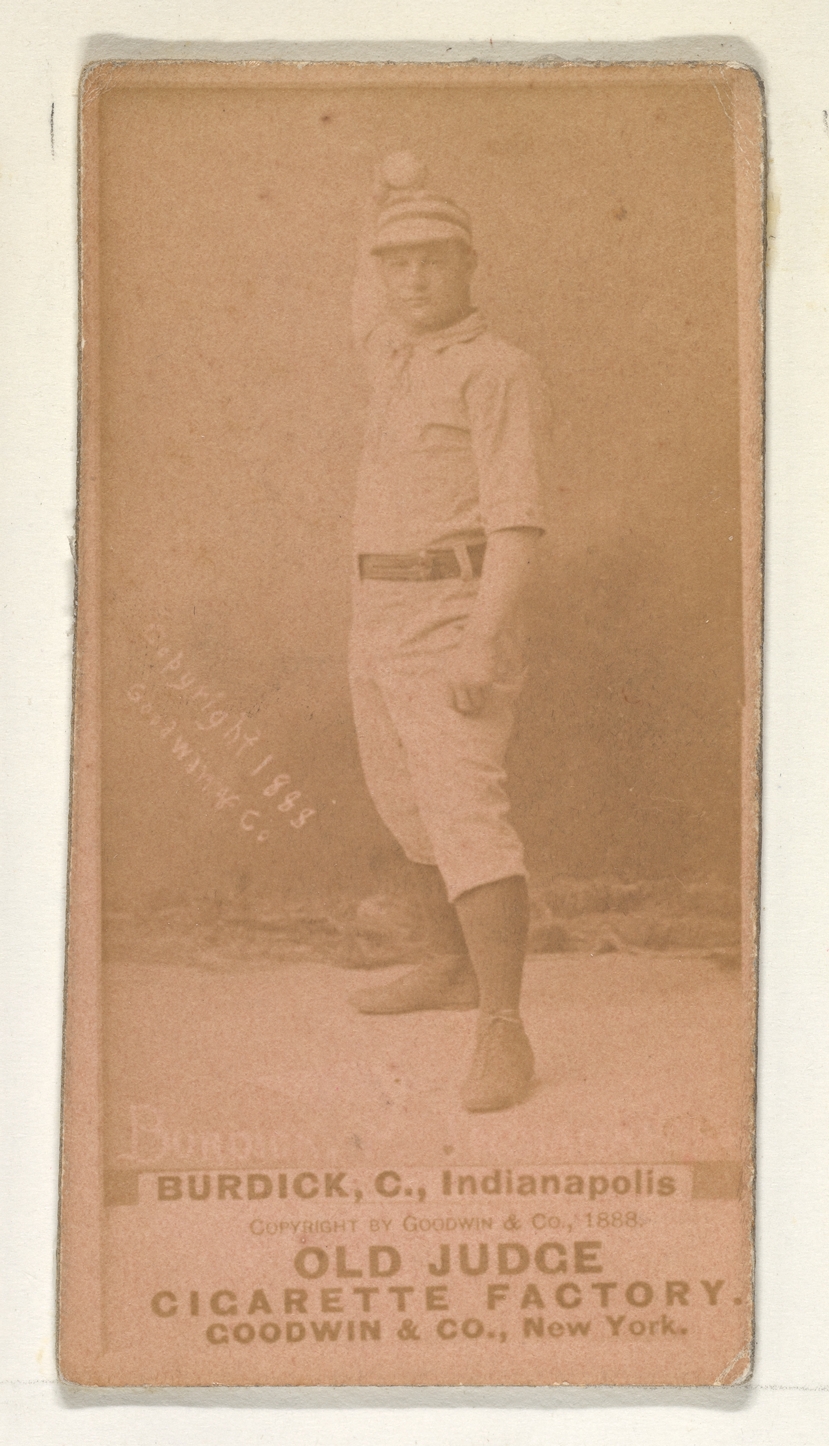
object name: baseball card, photograph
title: Burdick, Catcher, Indianapolis, from the Old Judge series (N172) for Old Judge Cigarettes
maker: goodwin & company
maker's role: publisher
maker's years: 1850-1950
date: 1888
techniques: albumen silver print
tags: men,portraits,baseball,athletes